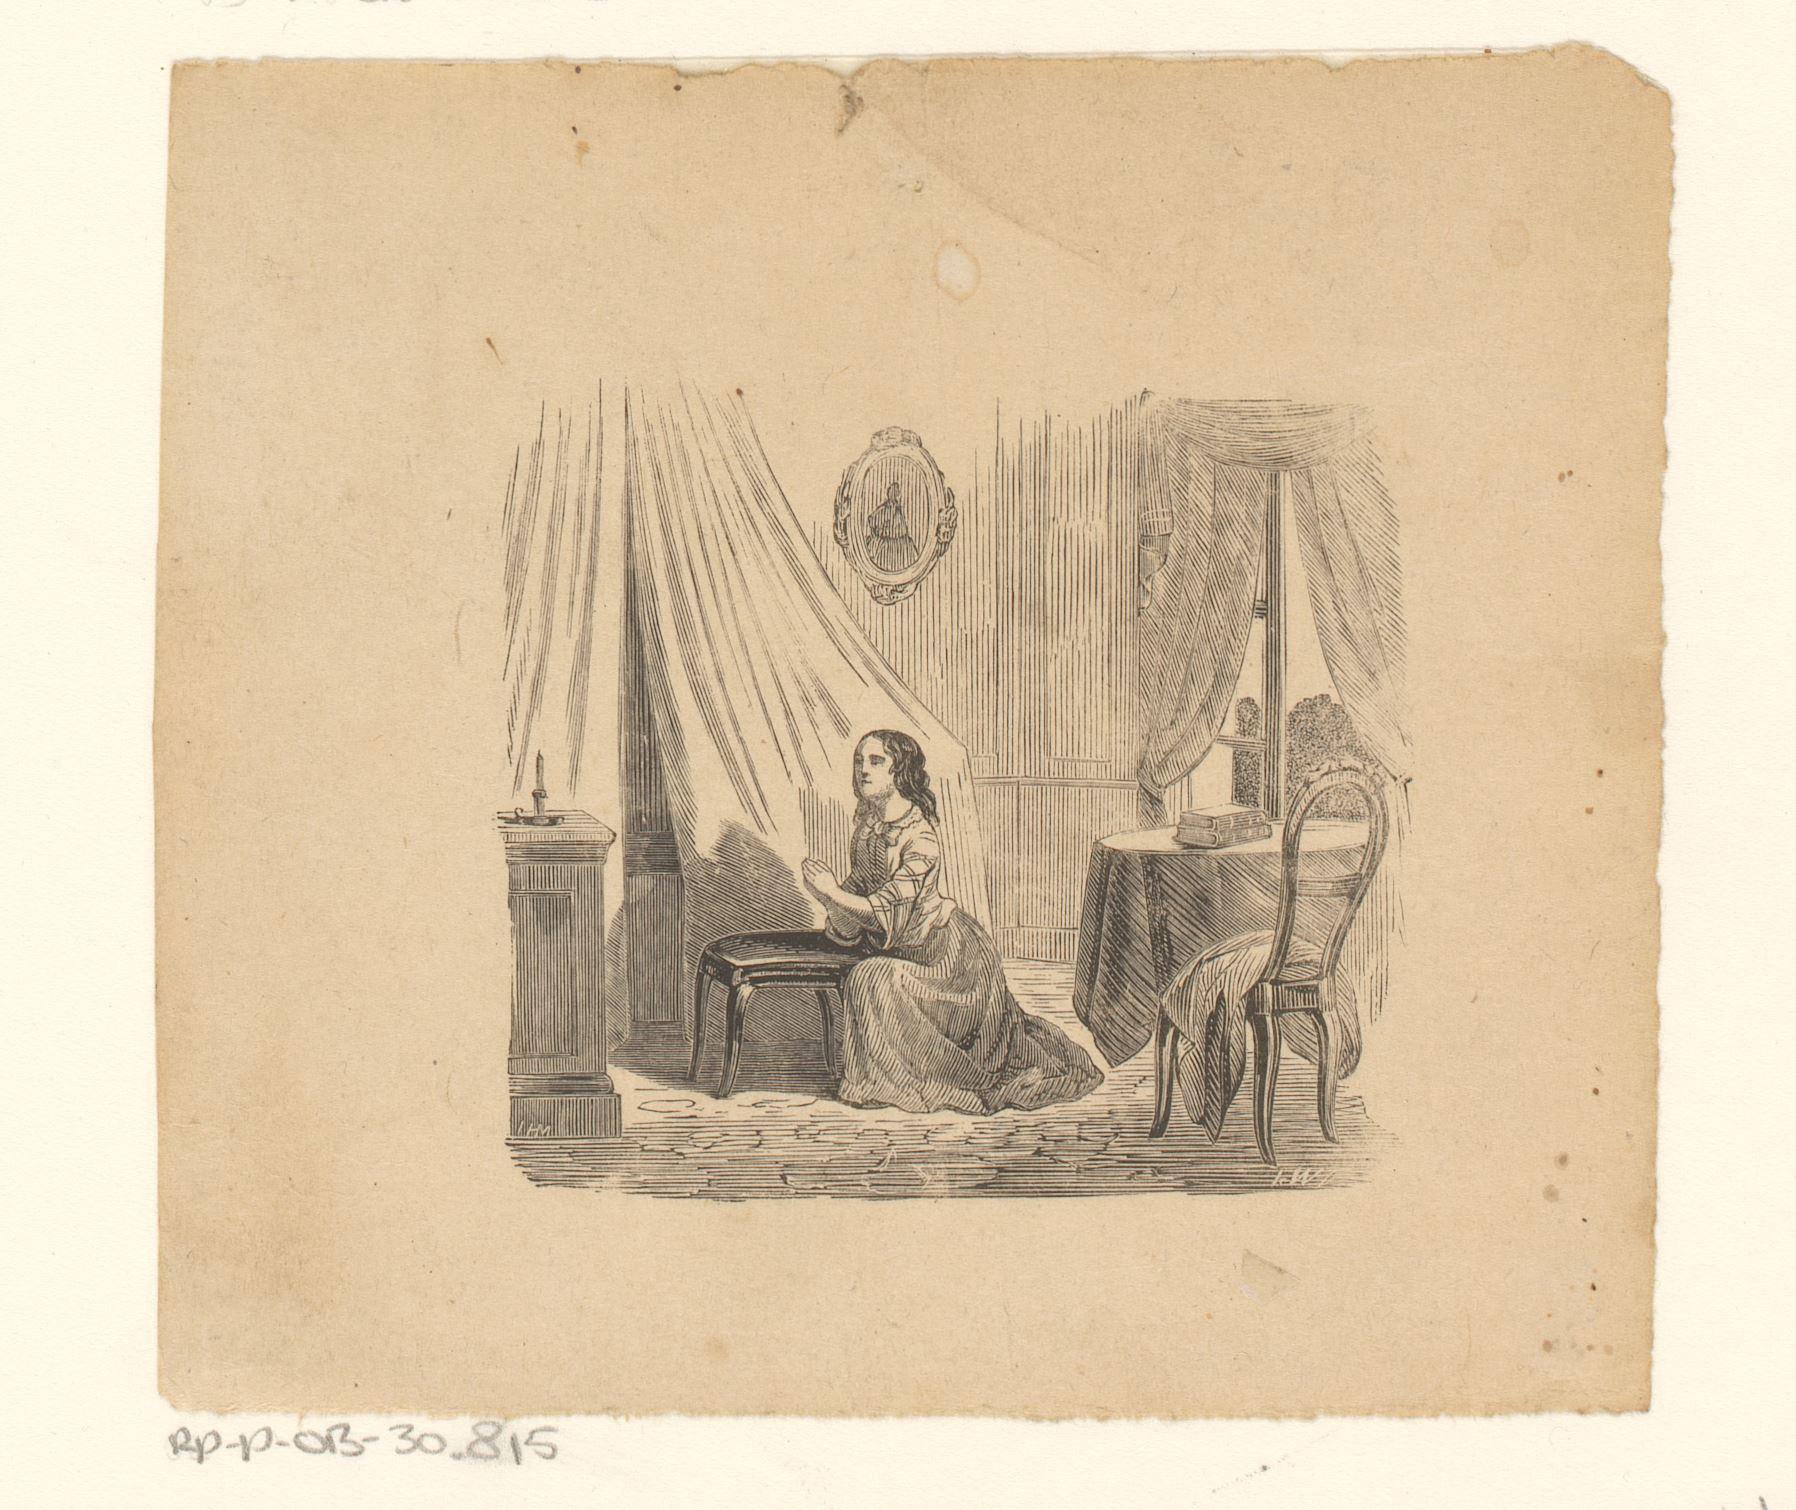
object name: print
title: Interieur met knielende jonge vrouw in gebed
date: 1836-1912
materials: paper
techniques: engraving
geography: netherlands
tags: adolescent, young woman, maiden (+ kneeling), one person praying